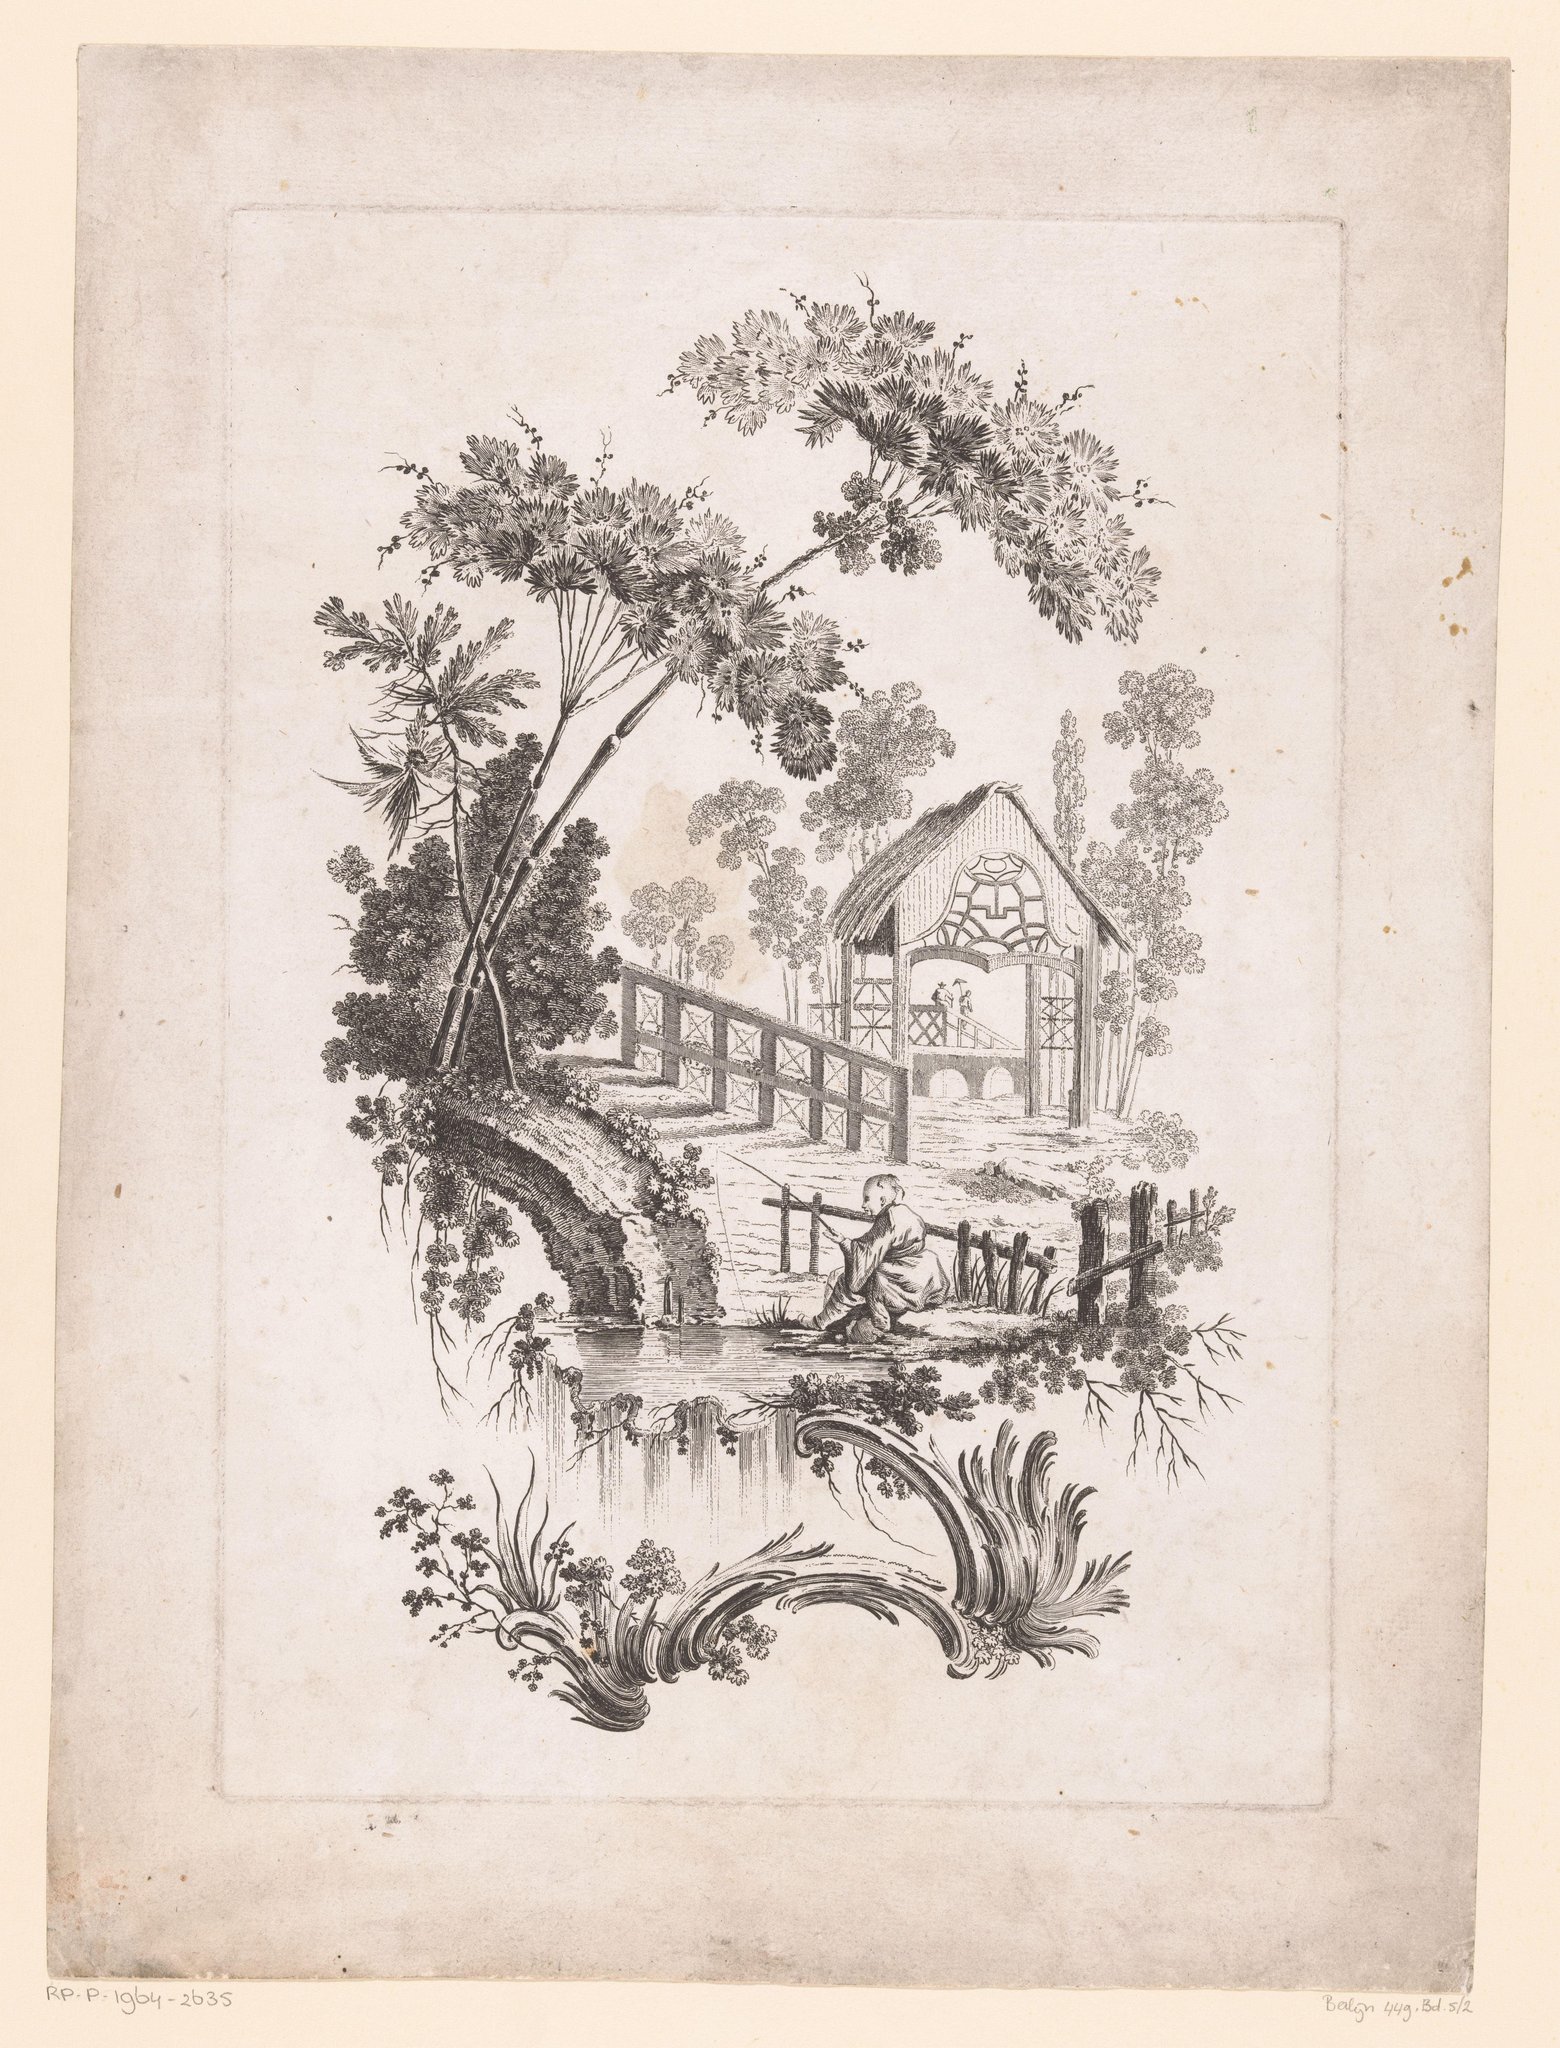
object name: ornament print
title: Recueil De Differents Panneaux Chinois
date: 1755-1775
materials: paper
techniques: etching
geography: paris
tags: city-view, and landscape with man-made constructions - ii - ideal landscapes, fishing (sports)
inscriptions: collector's mark: Lugt 2760, collector's mark: Lugt 2228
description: Een Chinese man zit langs de oever te vissen. In de achtergrond een landschap met bruggen en een gebouw.